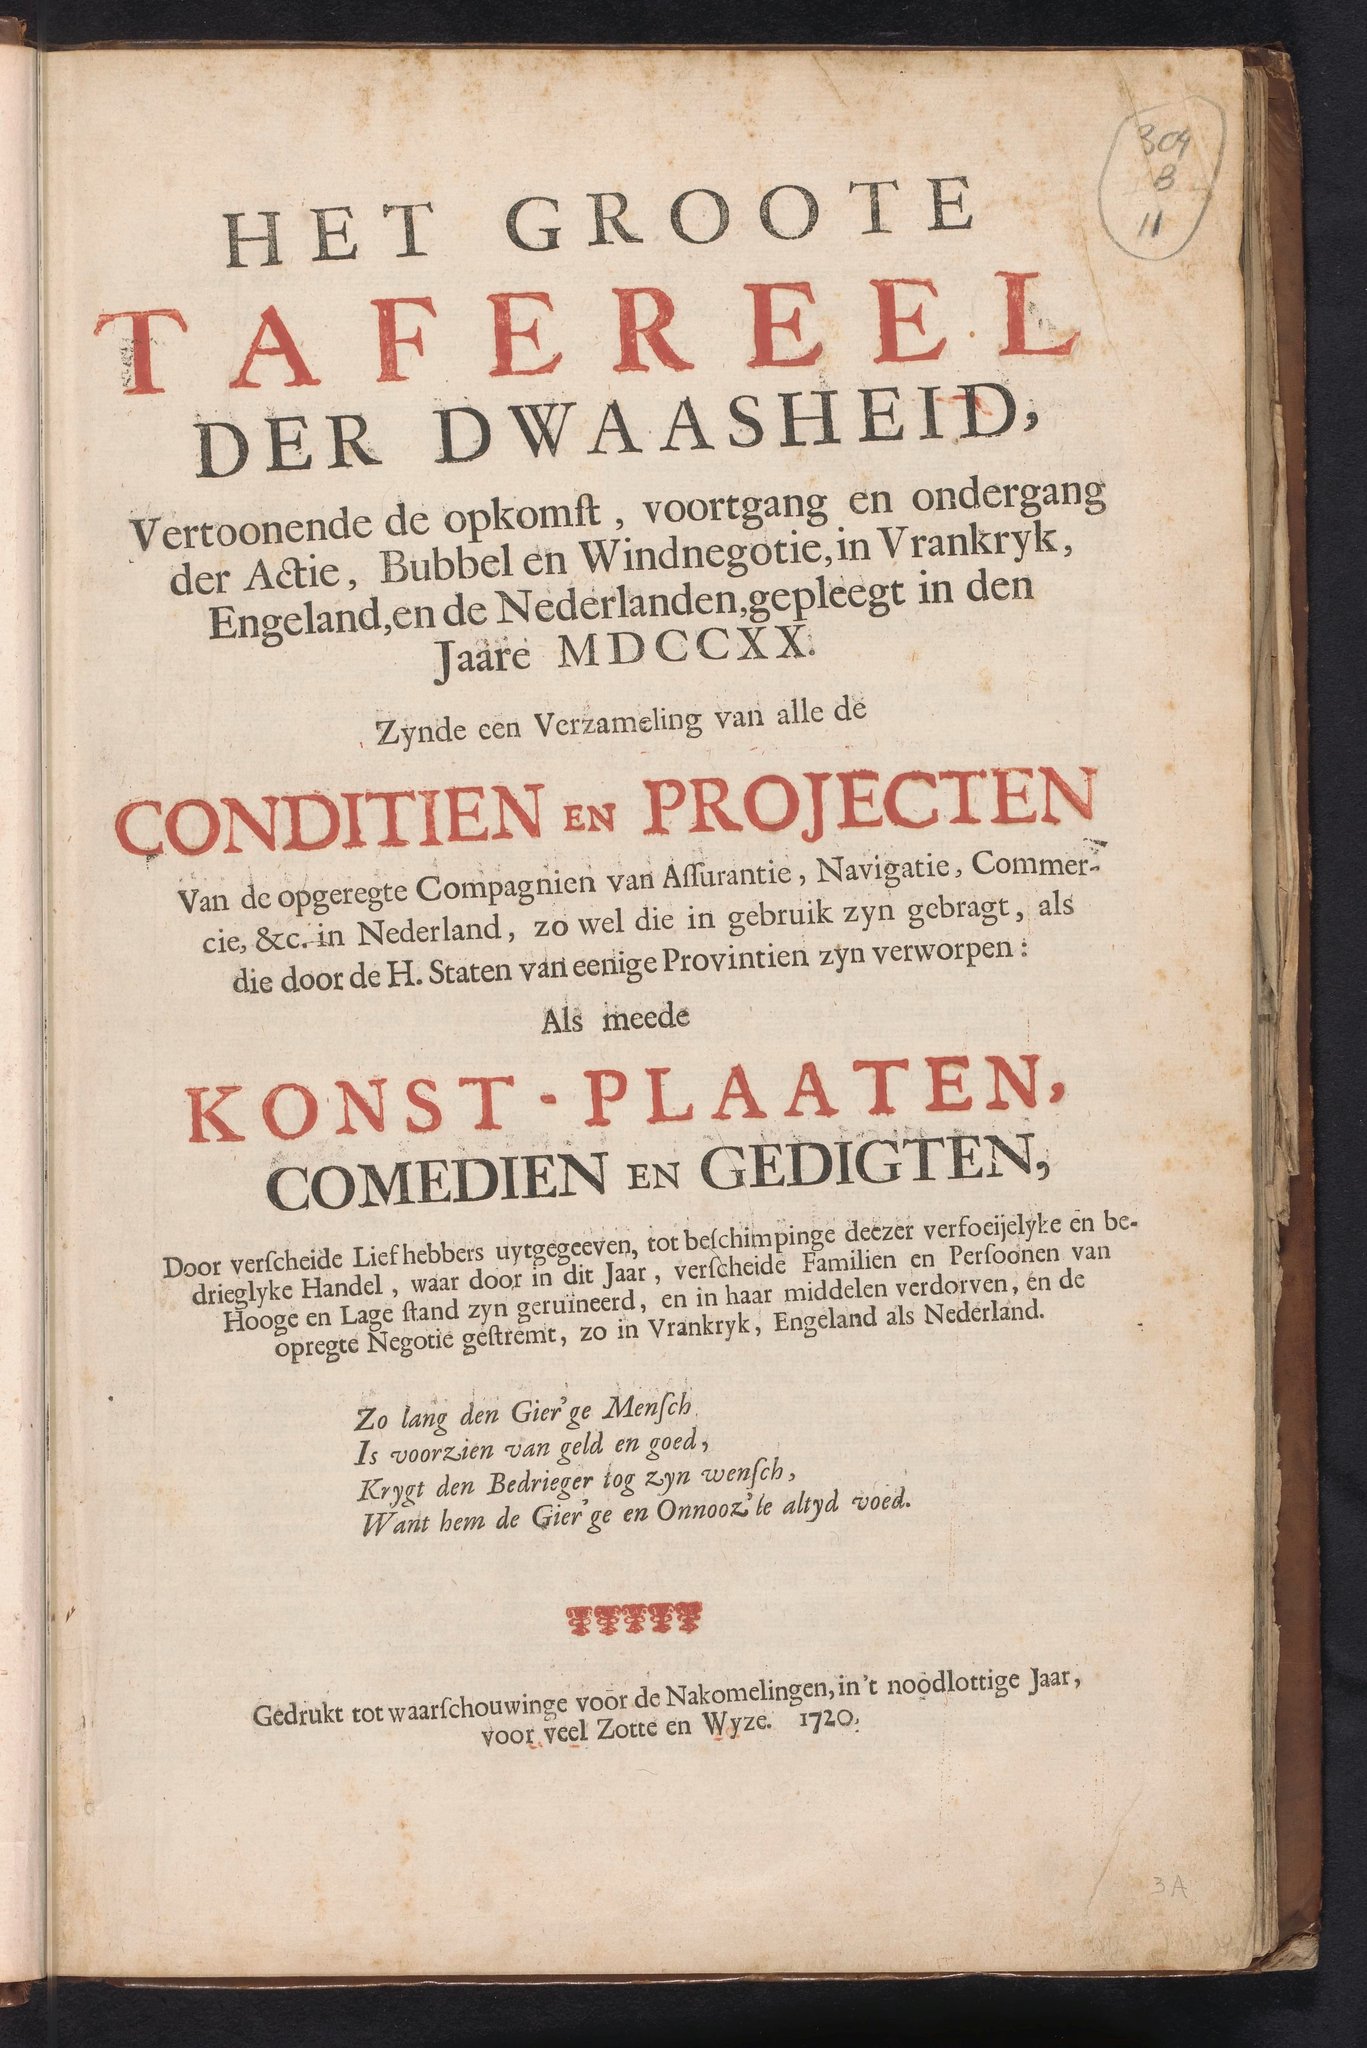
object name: titelblad, titelpagina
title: Titelpagina van: Het Groote Tafereel der Dwaasheid, 1720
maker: Anonymous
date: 1720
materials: paper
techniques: letterpress printing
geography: northern netherlands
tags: windhandel van 1720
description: Gedrukte titelpagina van Het Groote Tafereel der Dwaasheid, 1720. Titelpagina in de gebonden vierde uitgave (304 B 11) van Het Groote Tafereel der Dwaasheid met spotprenten op de Windhandel of Actiehandel van 1720.